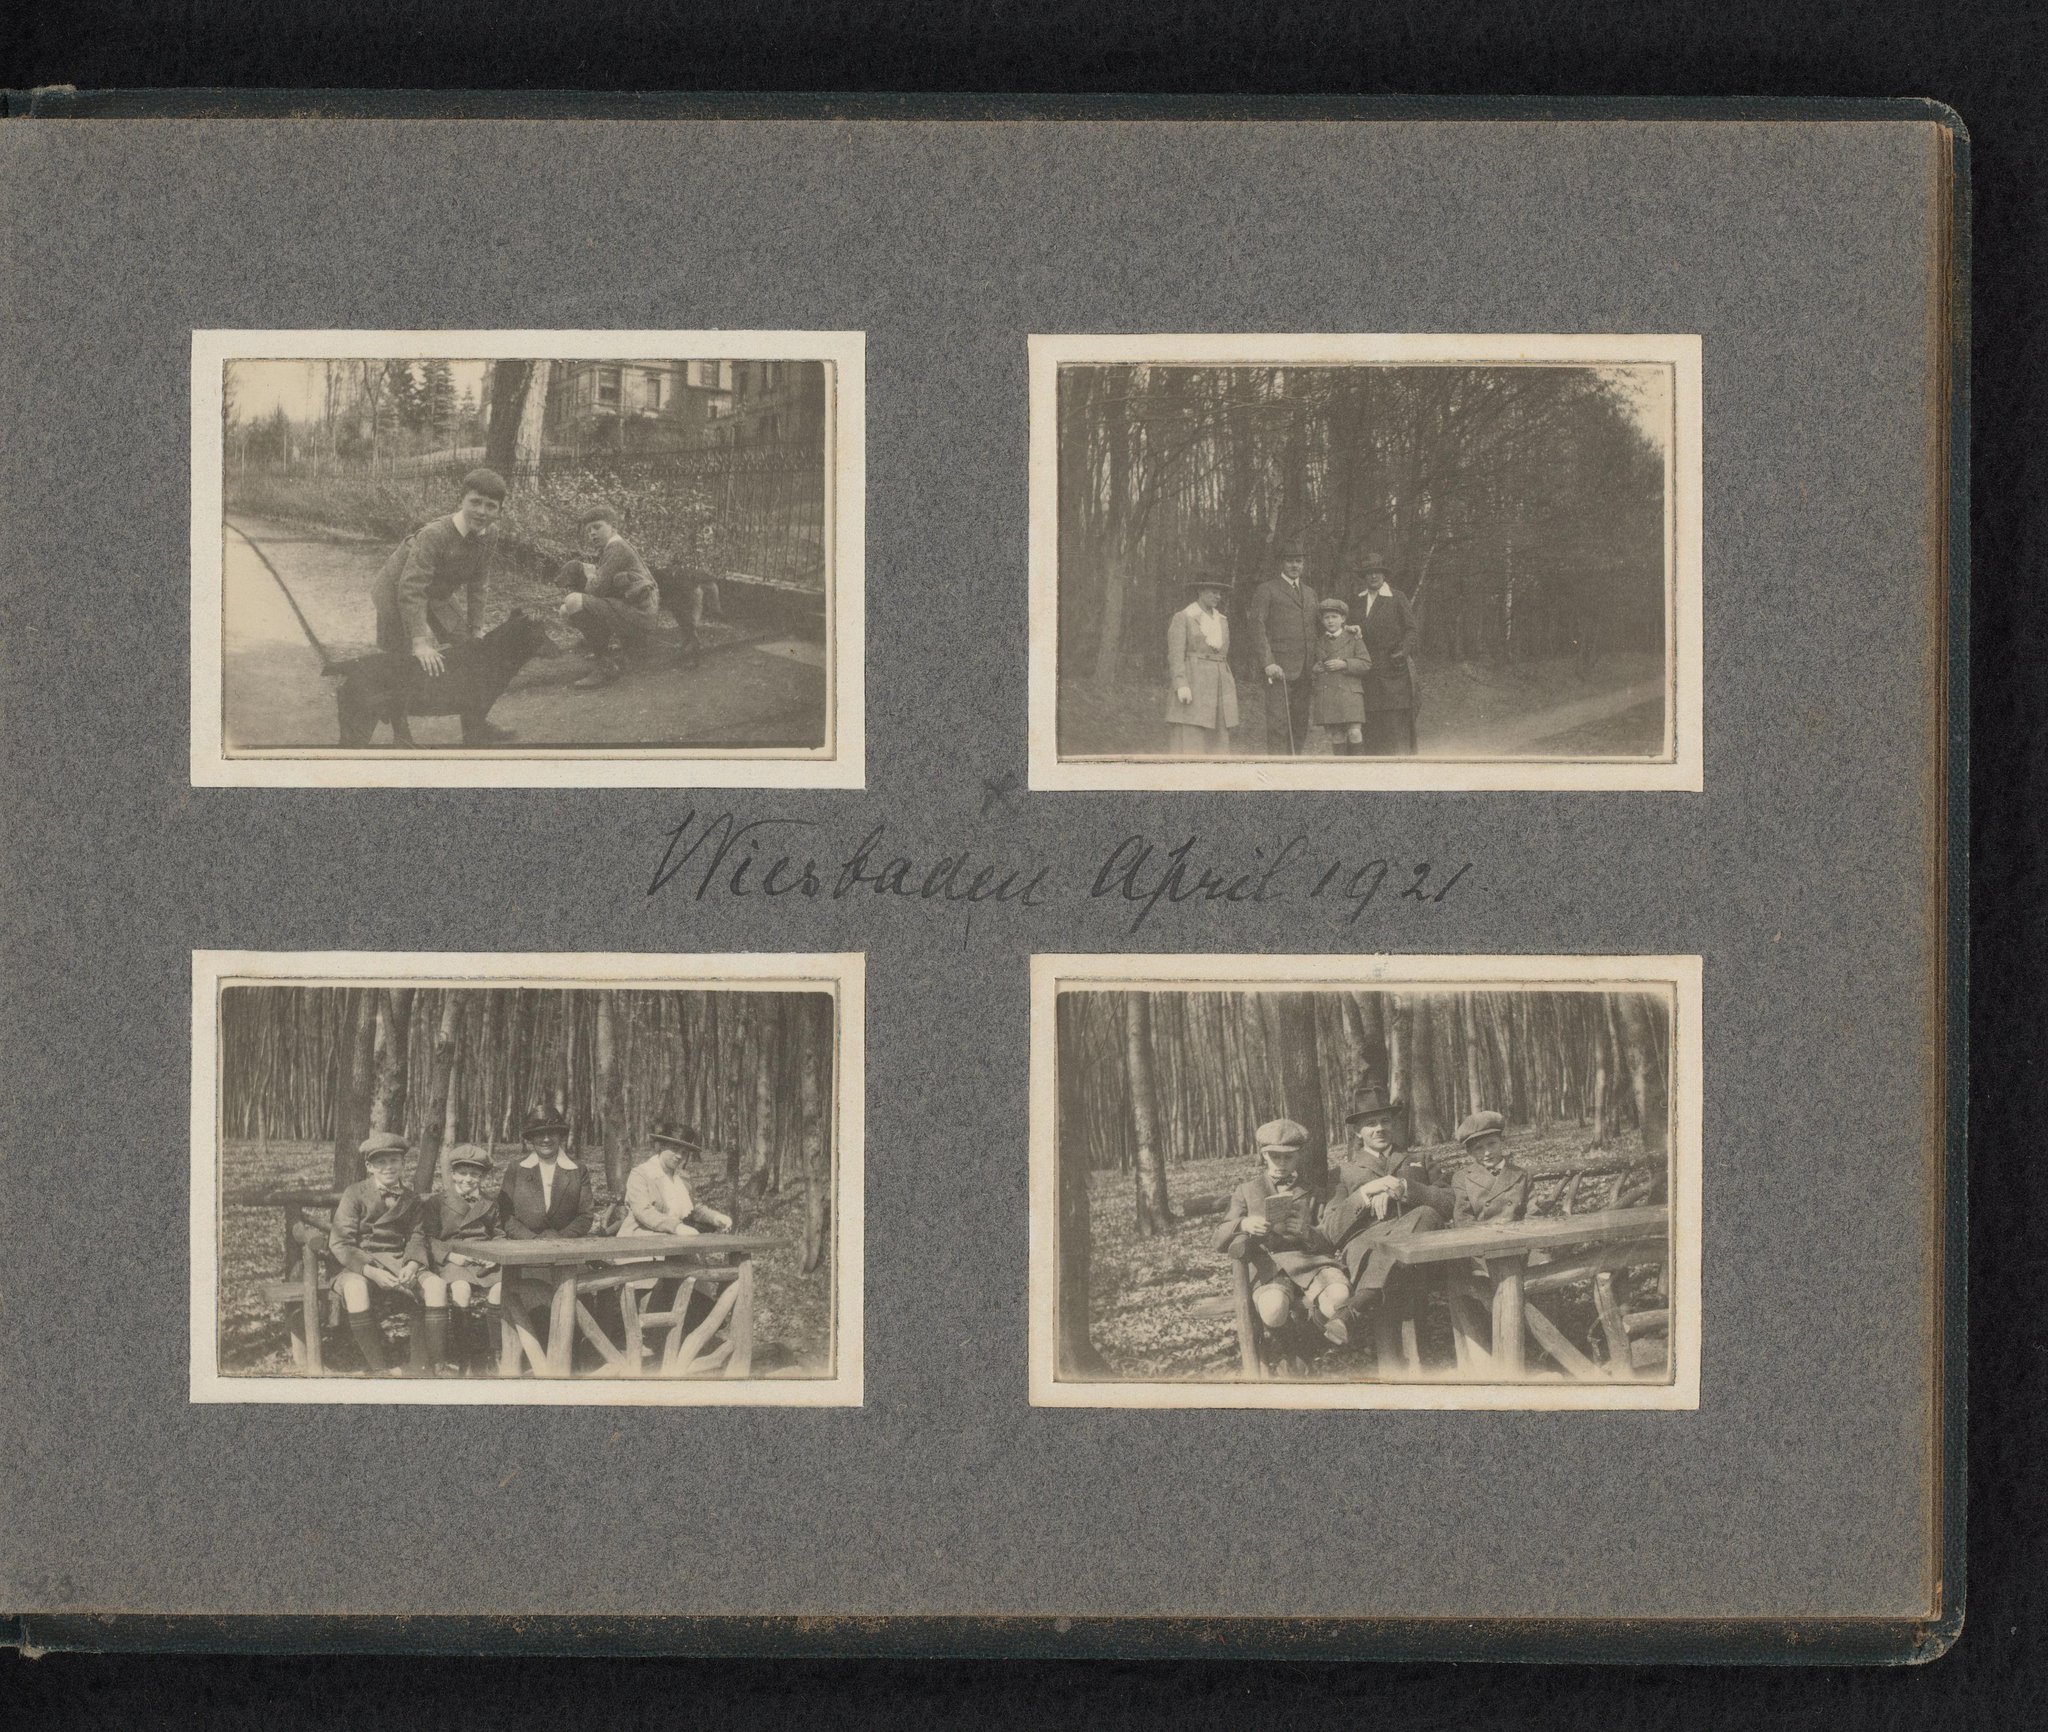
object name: photograph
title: Hendrik, Caroline, Carel en Frank van den berg in Wiesbaden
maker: hendrik herman van den berg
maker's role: amateurfotograaf, jurist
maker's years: 1875-1944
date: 1904-1921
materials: paper, cardboard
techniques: gelatin silver print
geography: wiesbaden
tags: batavia, hendrik herman van den berg, the hague, caroline louise van den berg-van den berg, carel frederik van den berg (cay), amsterdam, frank willem van den berg (1912-1998), family life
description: Deze foto's zijn onderdeel van een album.